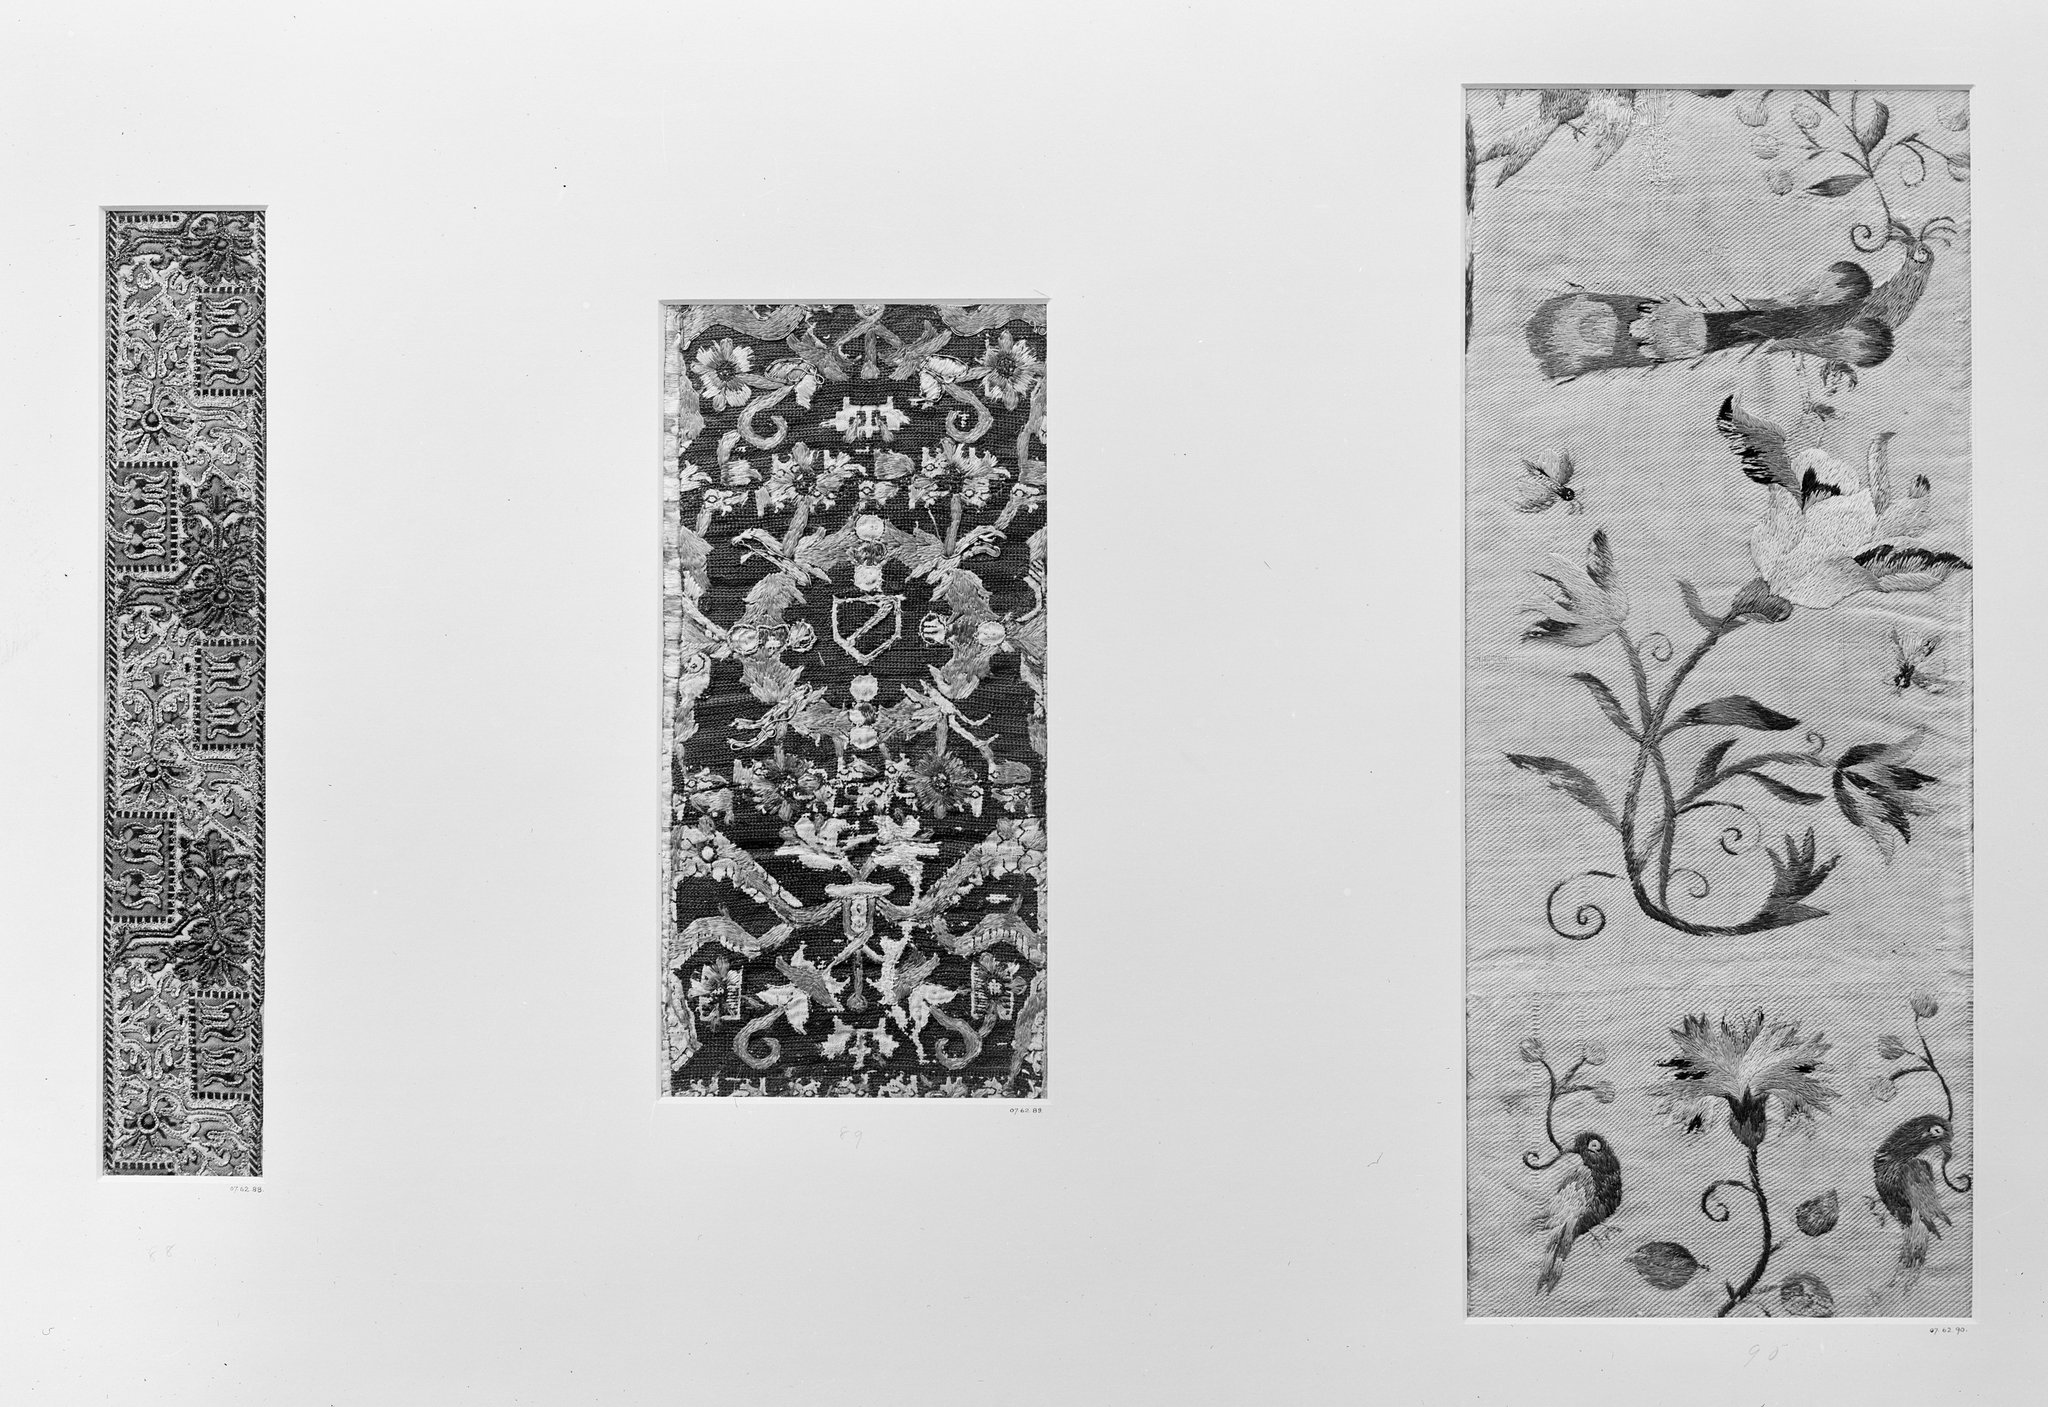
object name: fragment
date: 1701-1800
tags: birds,peacocks,flowers